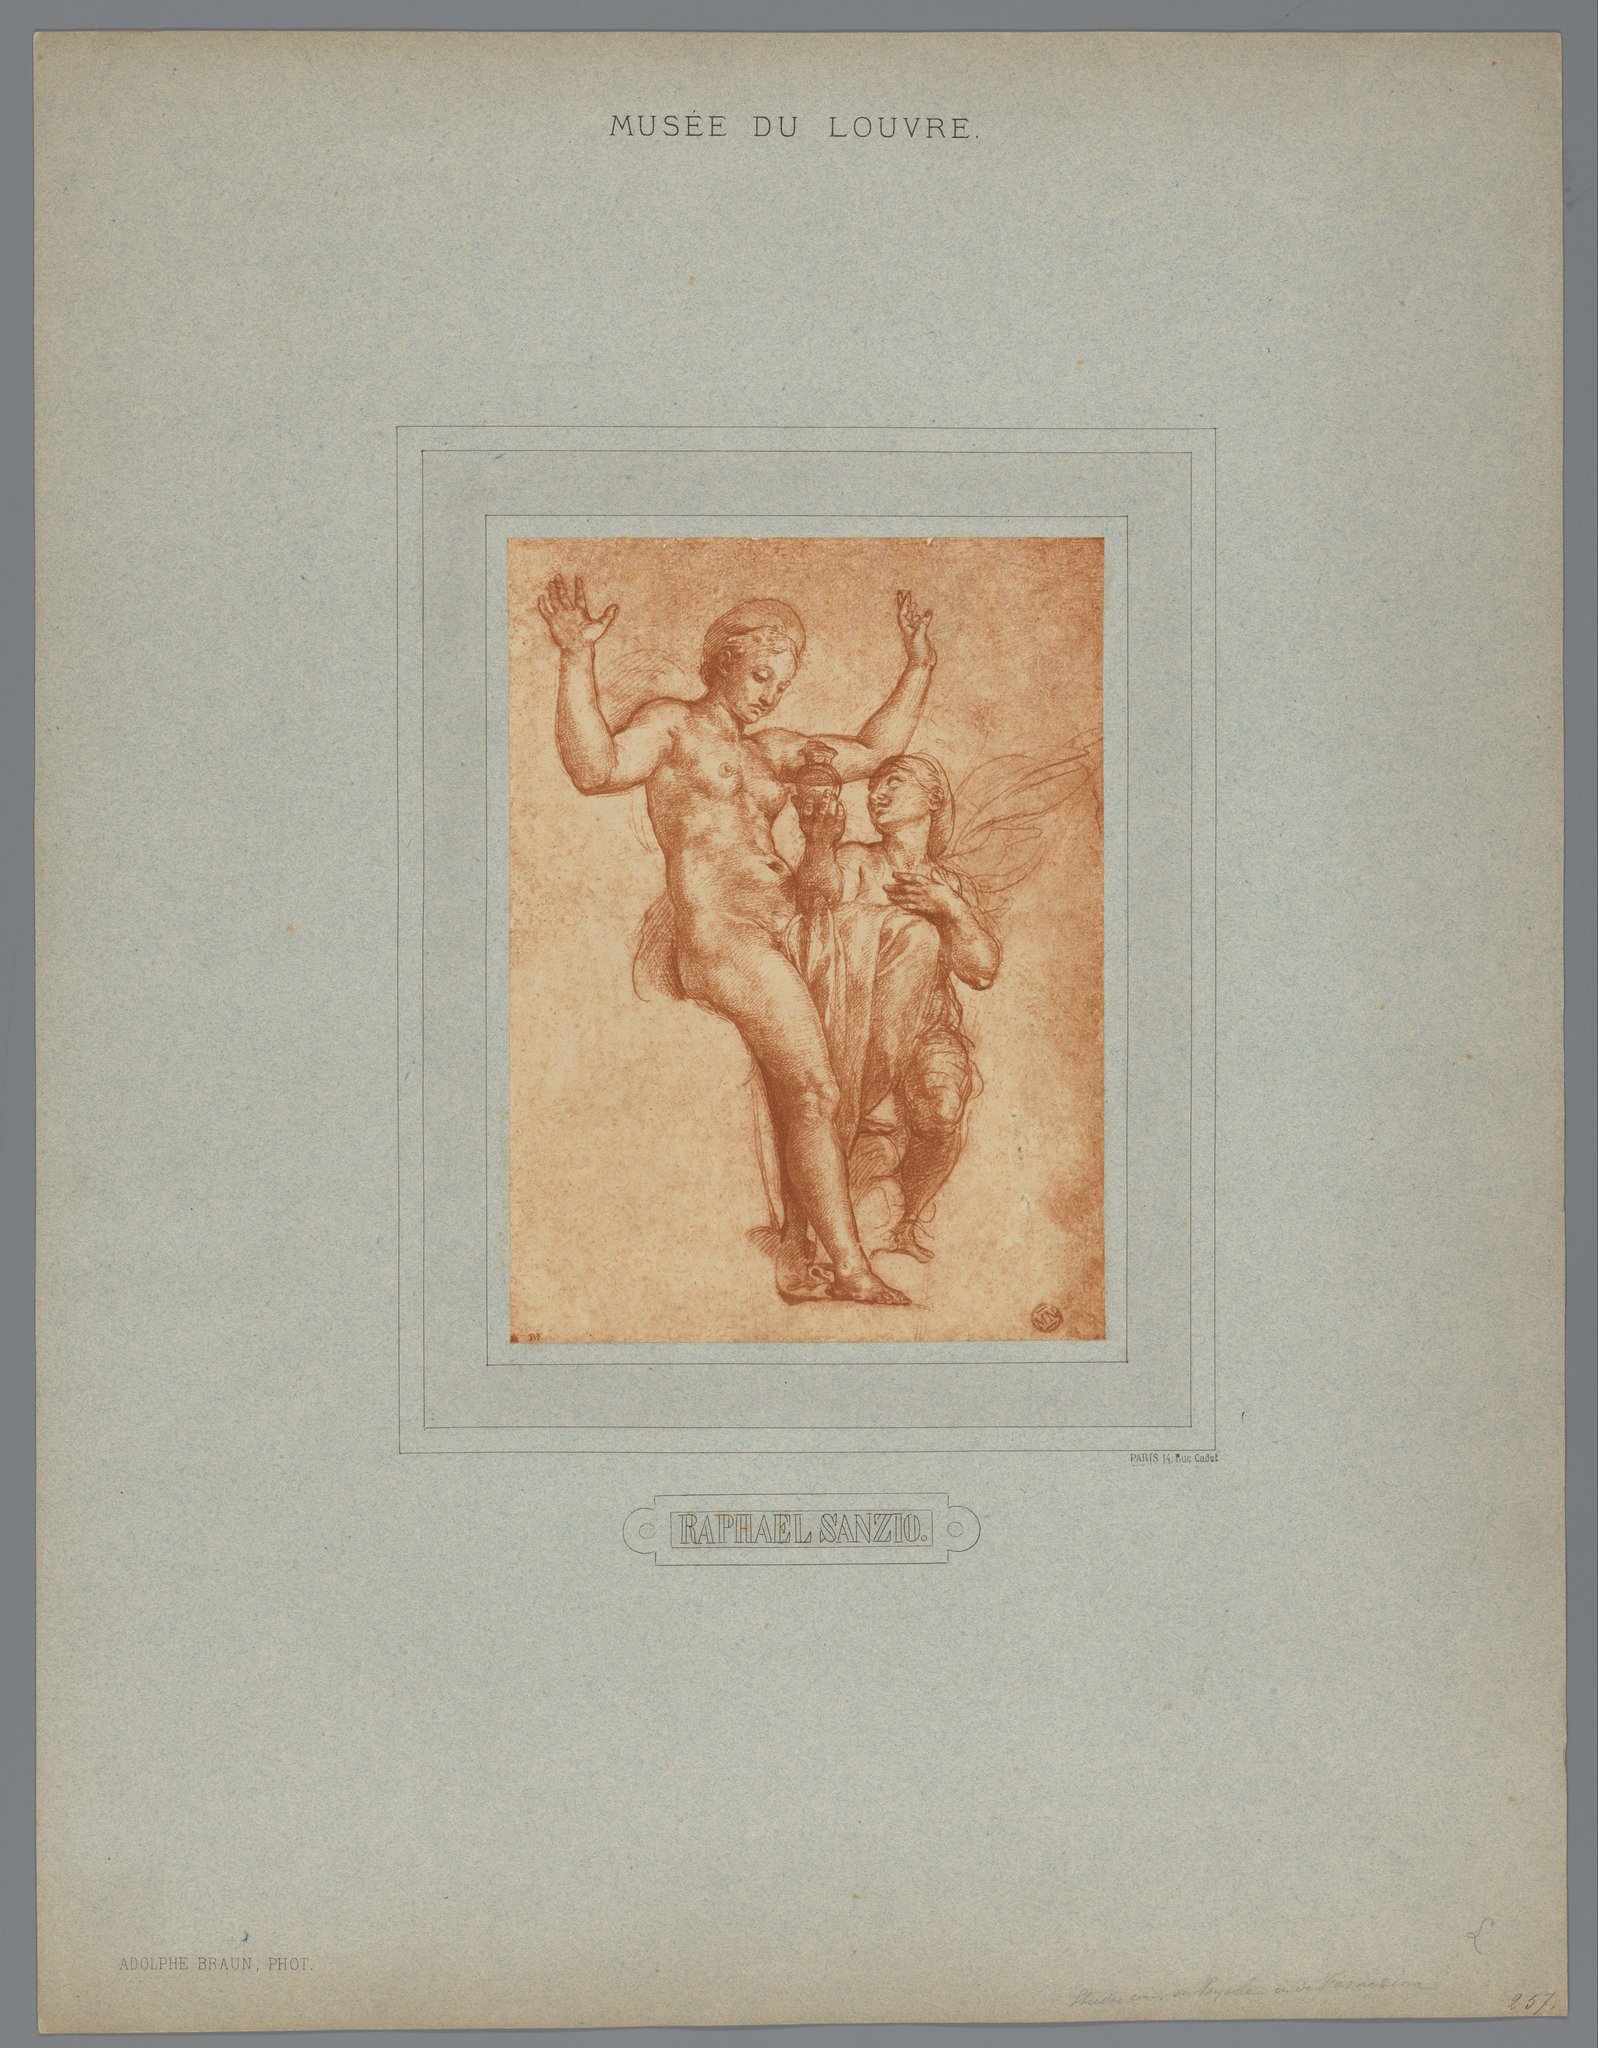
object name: photograph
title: Fotoreproductie van een tekening van Rafaël (twee engelen?) (coll. Louvre)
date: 1880-1900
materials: cardboard, paper, photographic support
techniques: carbon print